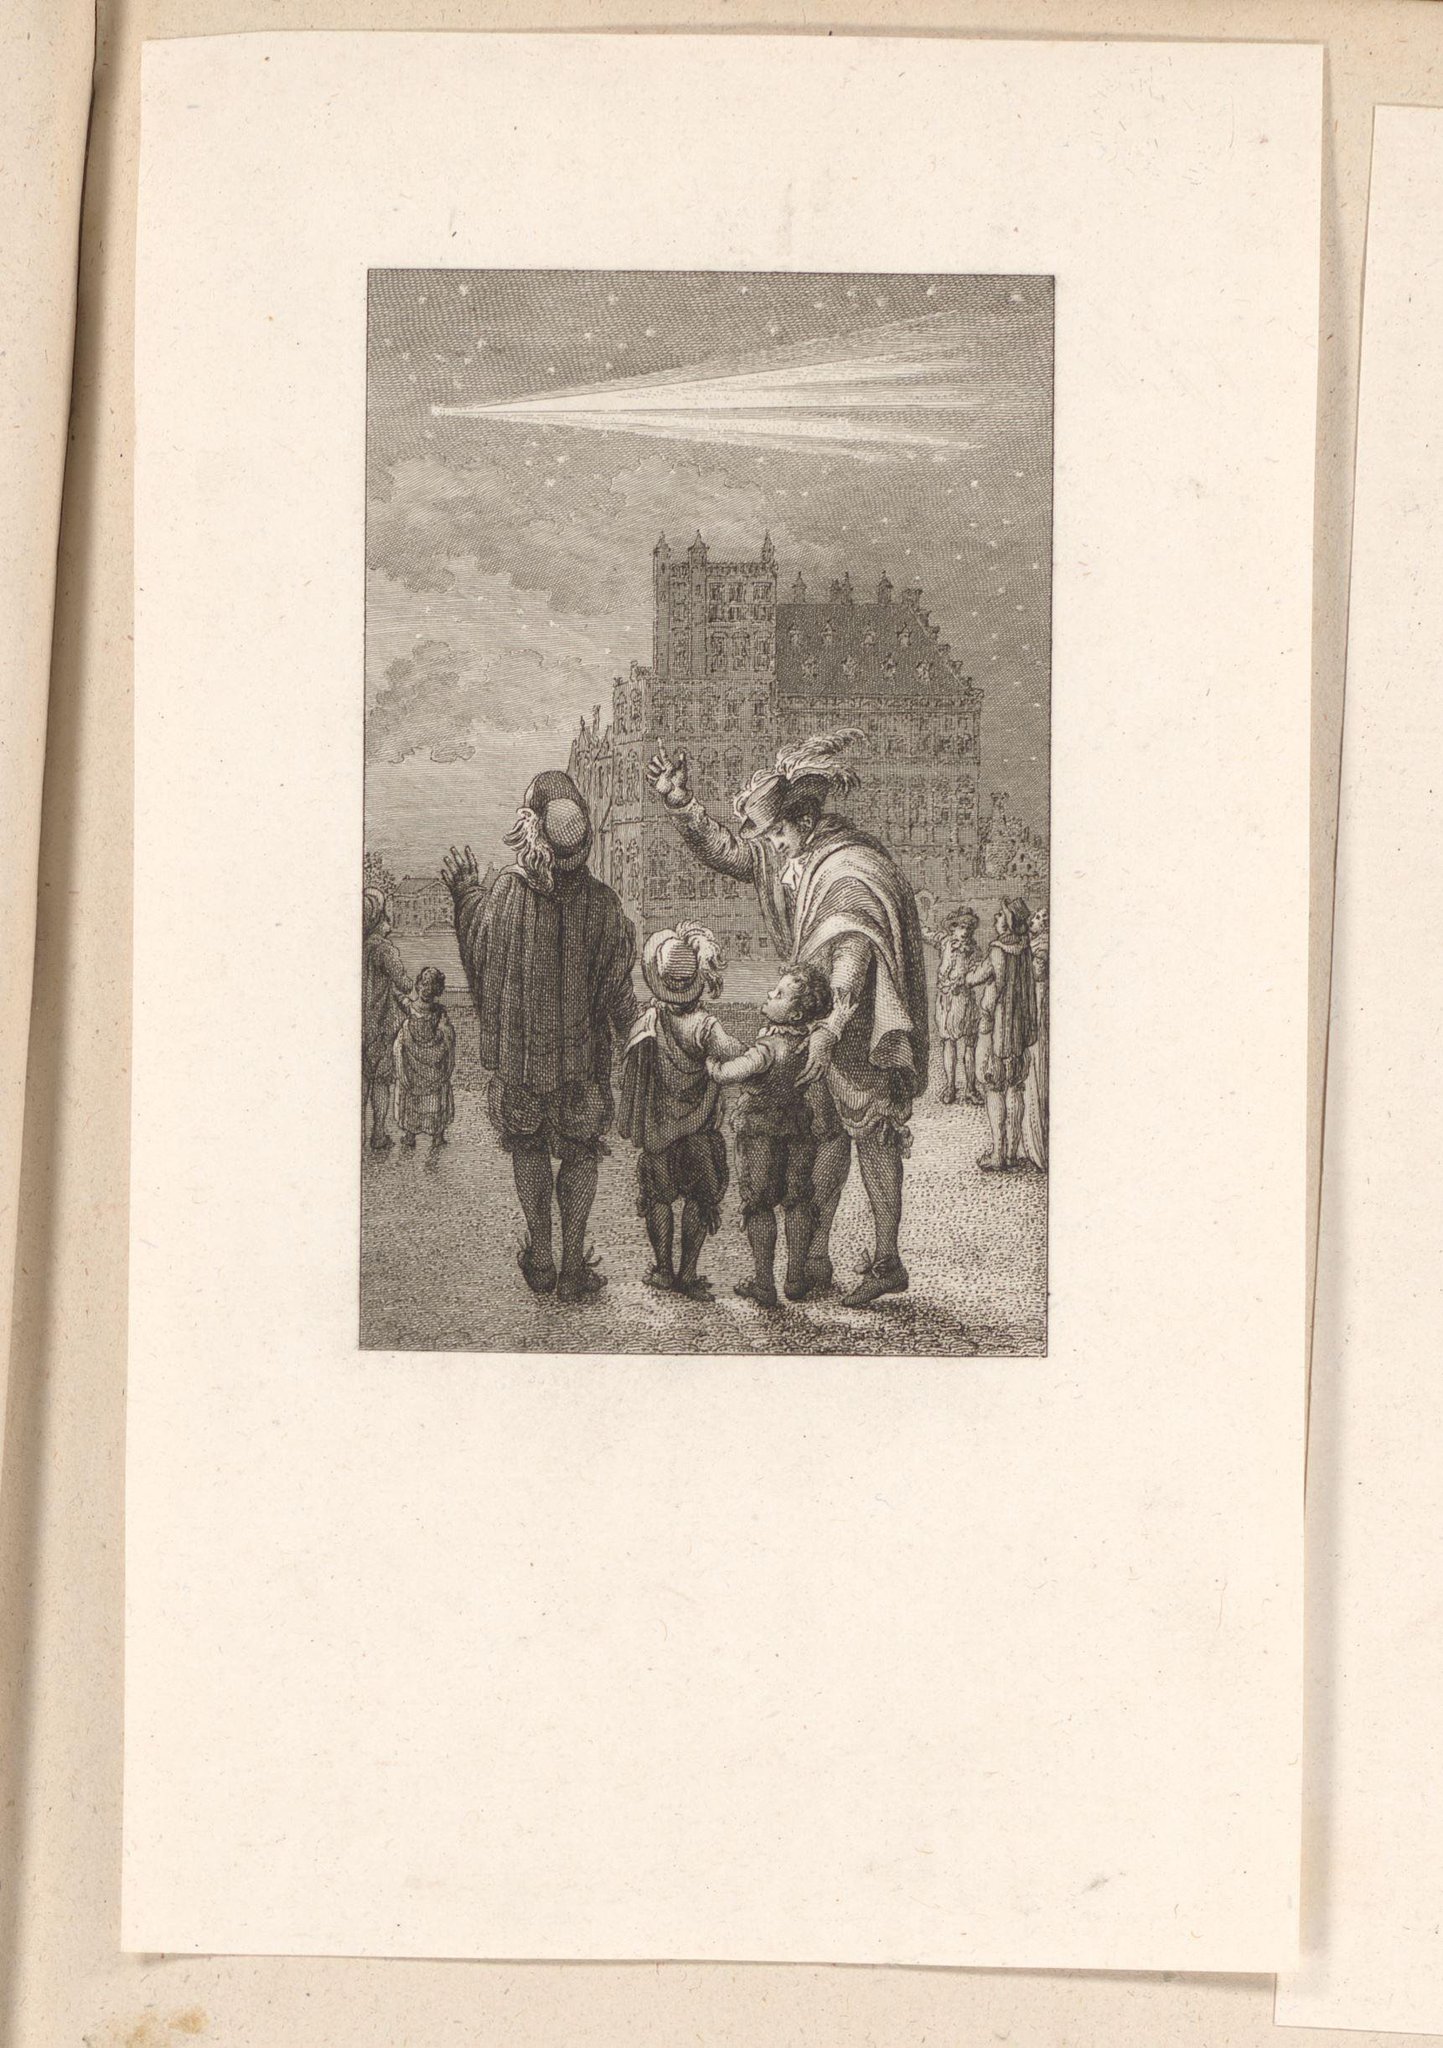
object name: album leaf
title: Sterren kijken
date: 1815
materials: paper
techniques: engraving, etching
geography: haarlem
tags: stars, firmament, sky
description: Bij een stadspaleis kijken twee mannen en twee kinderen naar de sterren. De man rechts wijst naar boven. De prent maakt deel uit van een album.